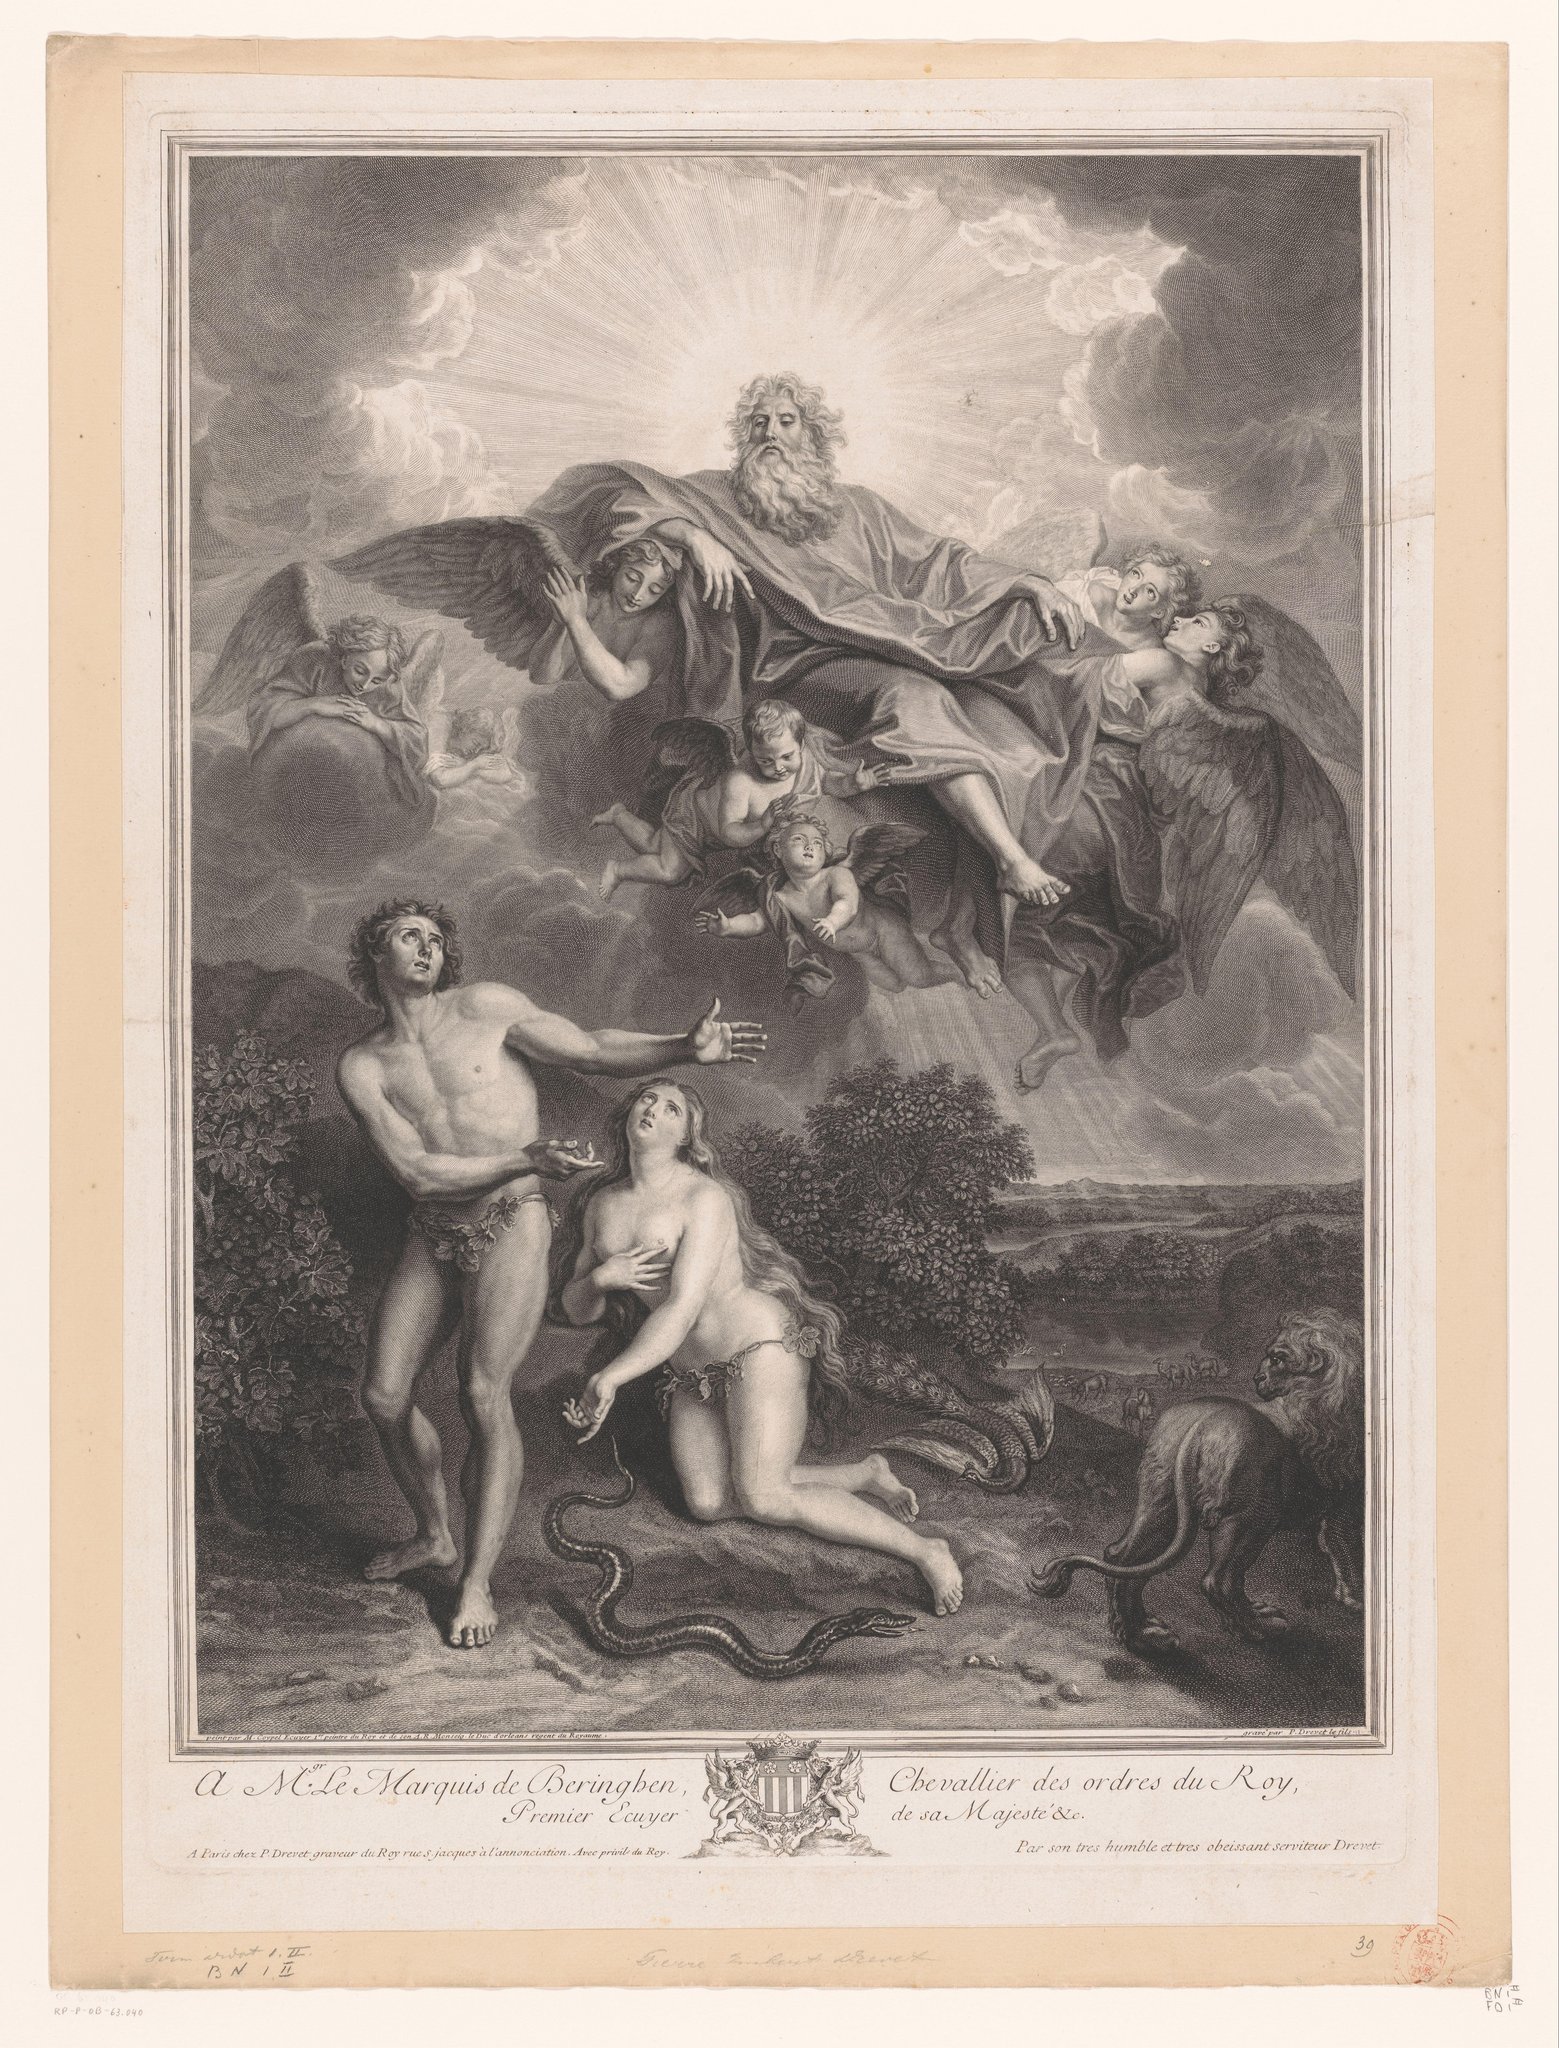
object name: print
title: Adam en Eva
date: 1707-1739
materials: paper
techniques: engraving, etching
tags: adam and eve reproved by god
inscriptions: collector's mark: Lugt 240